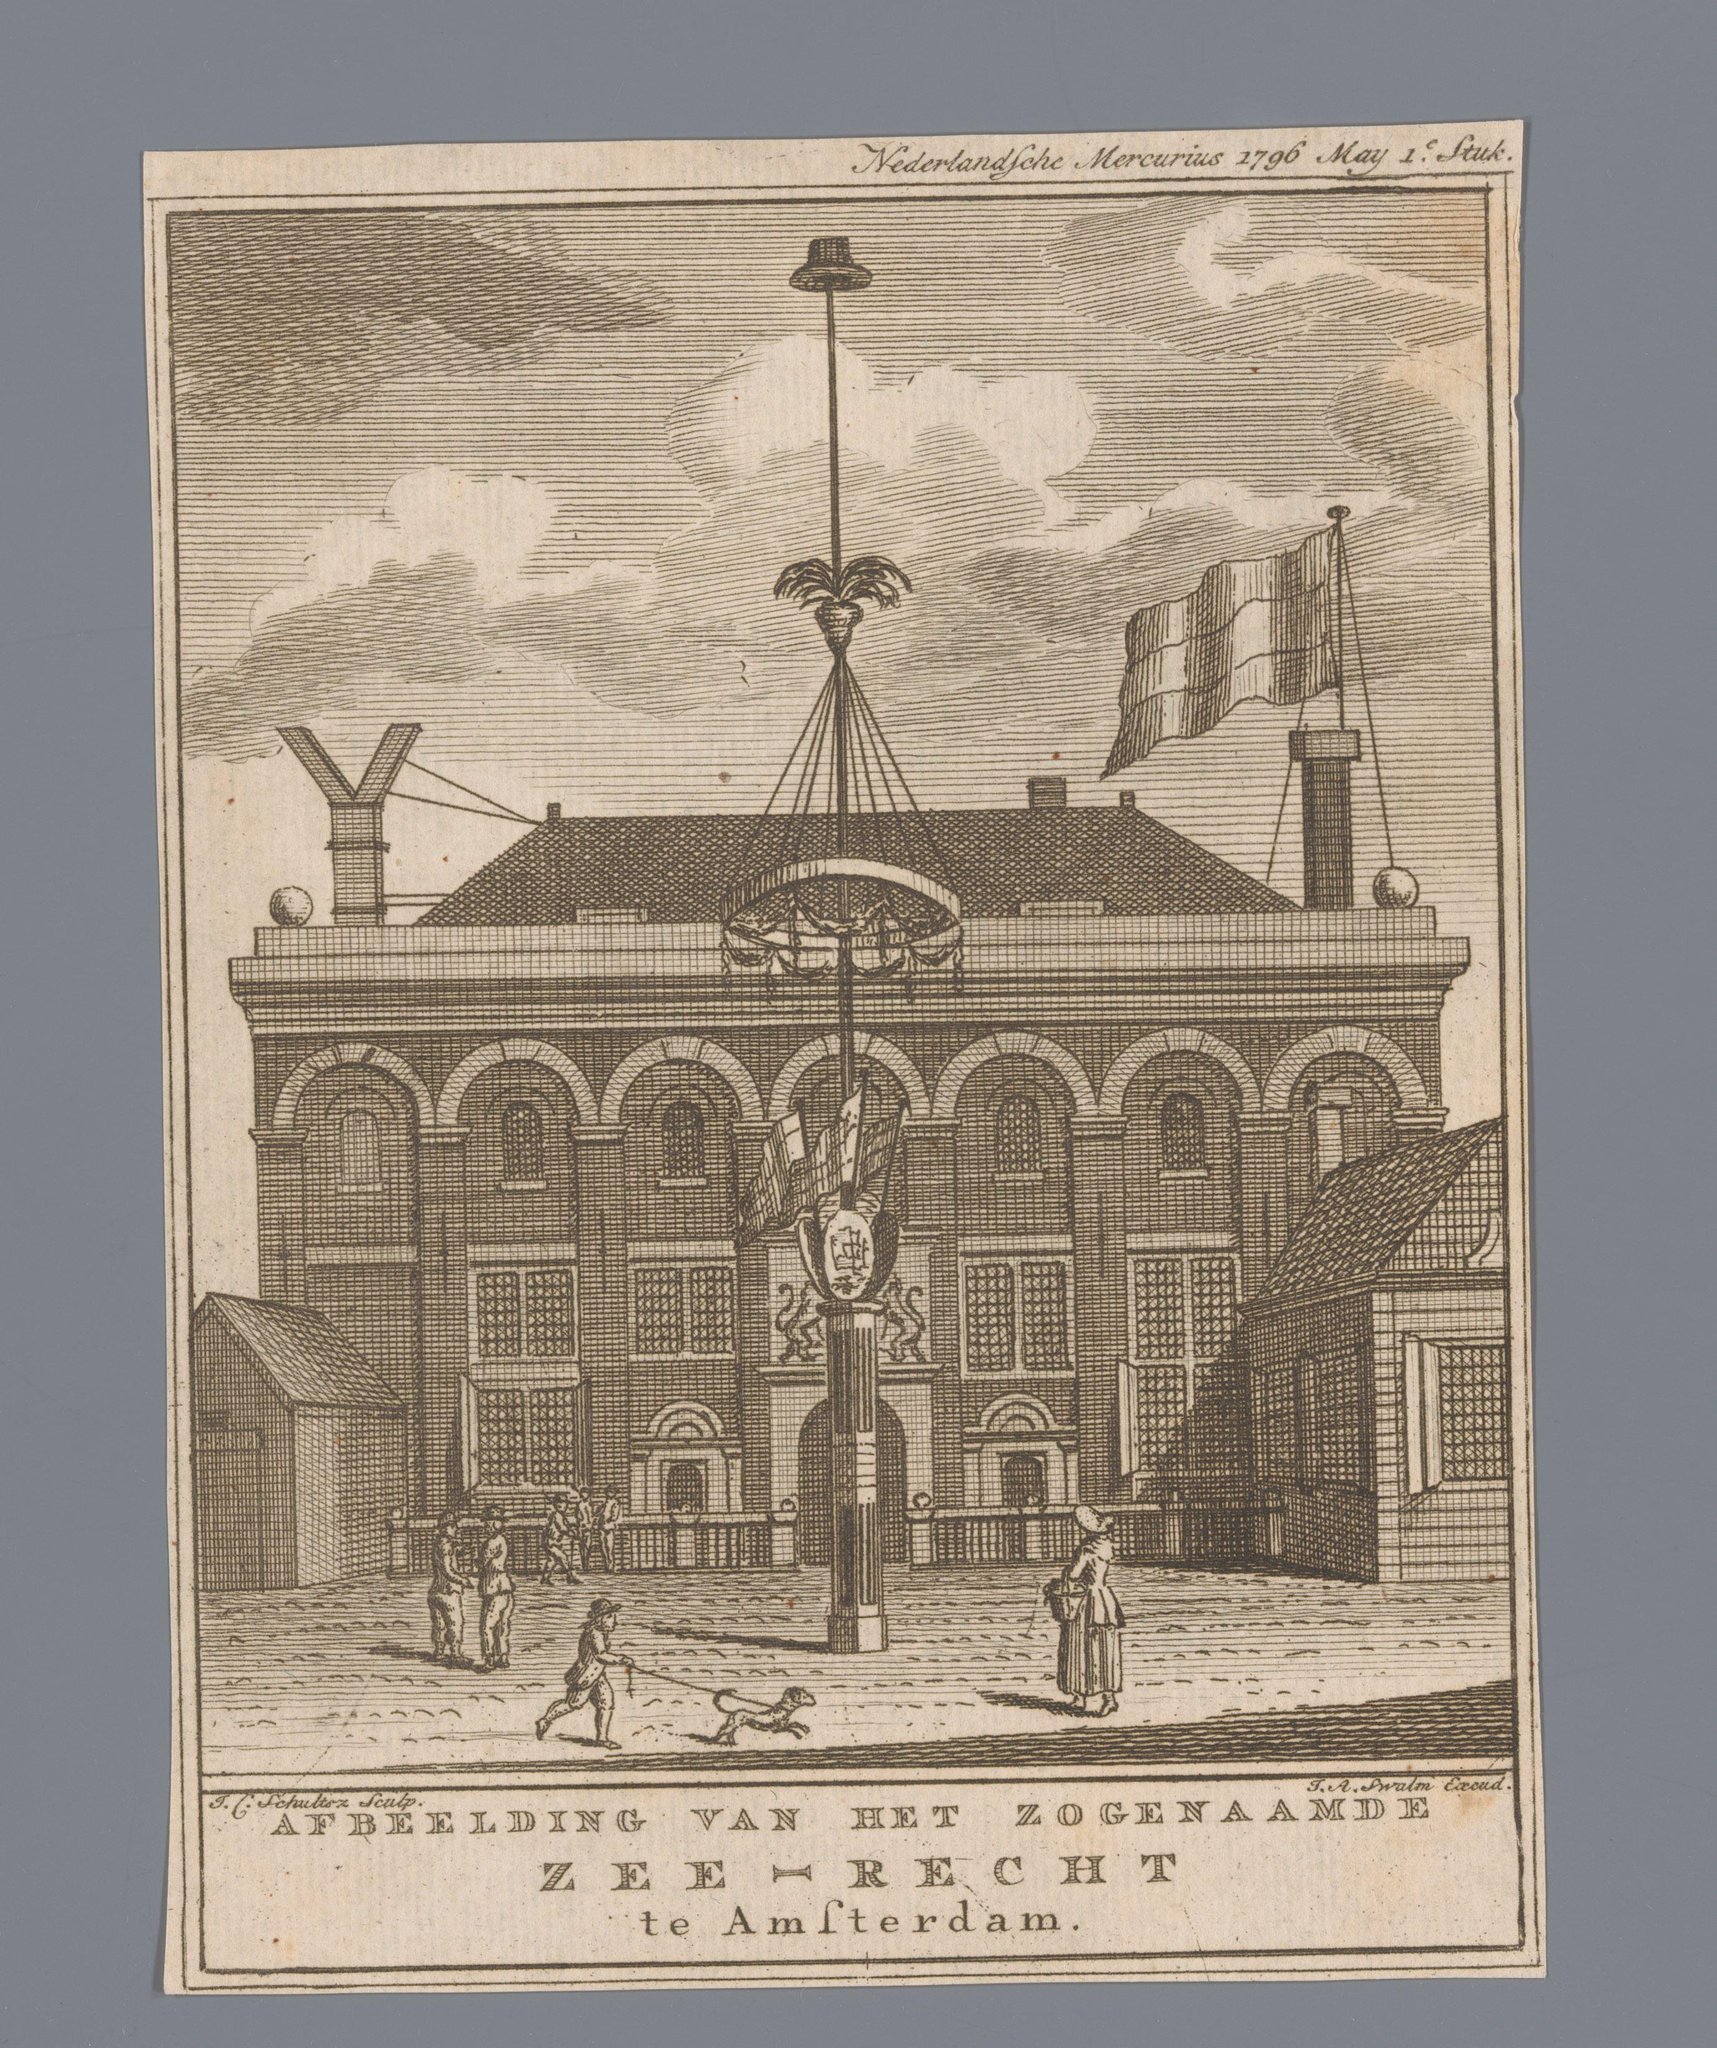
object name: print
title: Afbeelding van het zogenaamde Zee-Recht te Amsterdam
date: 1796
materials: paper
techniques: engraving, etching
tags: dancing around the tree of liberty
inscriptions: collector's mark: Lugt 2228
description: Voorgevel van het Zeerecht (Kampersteiger, tegenwoordig Prins Hendrikkade), met op de voorgrond de Vrijheidsboom.